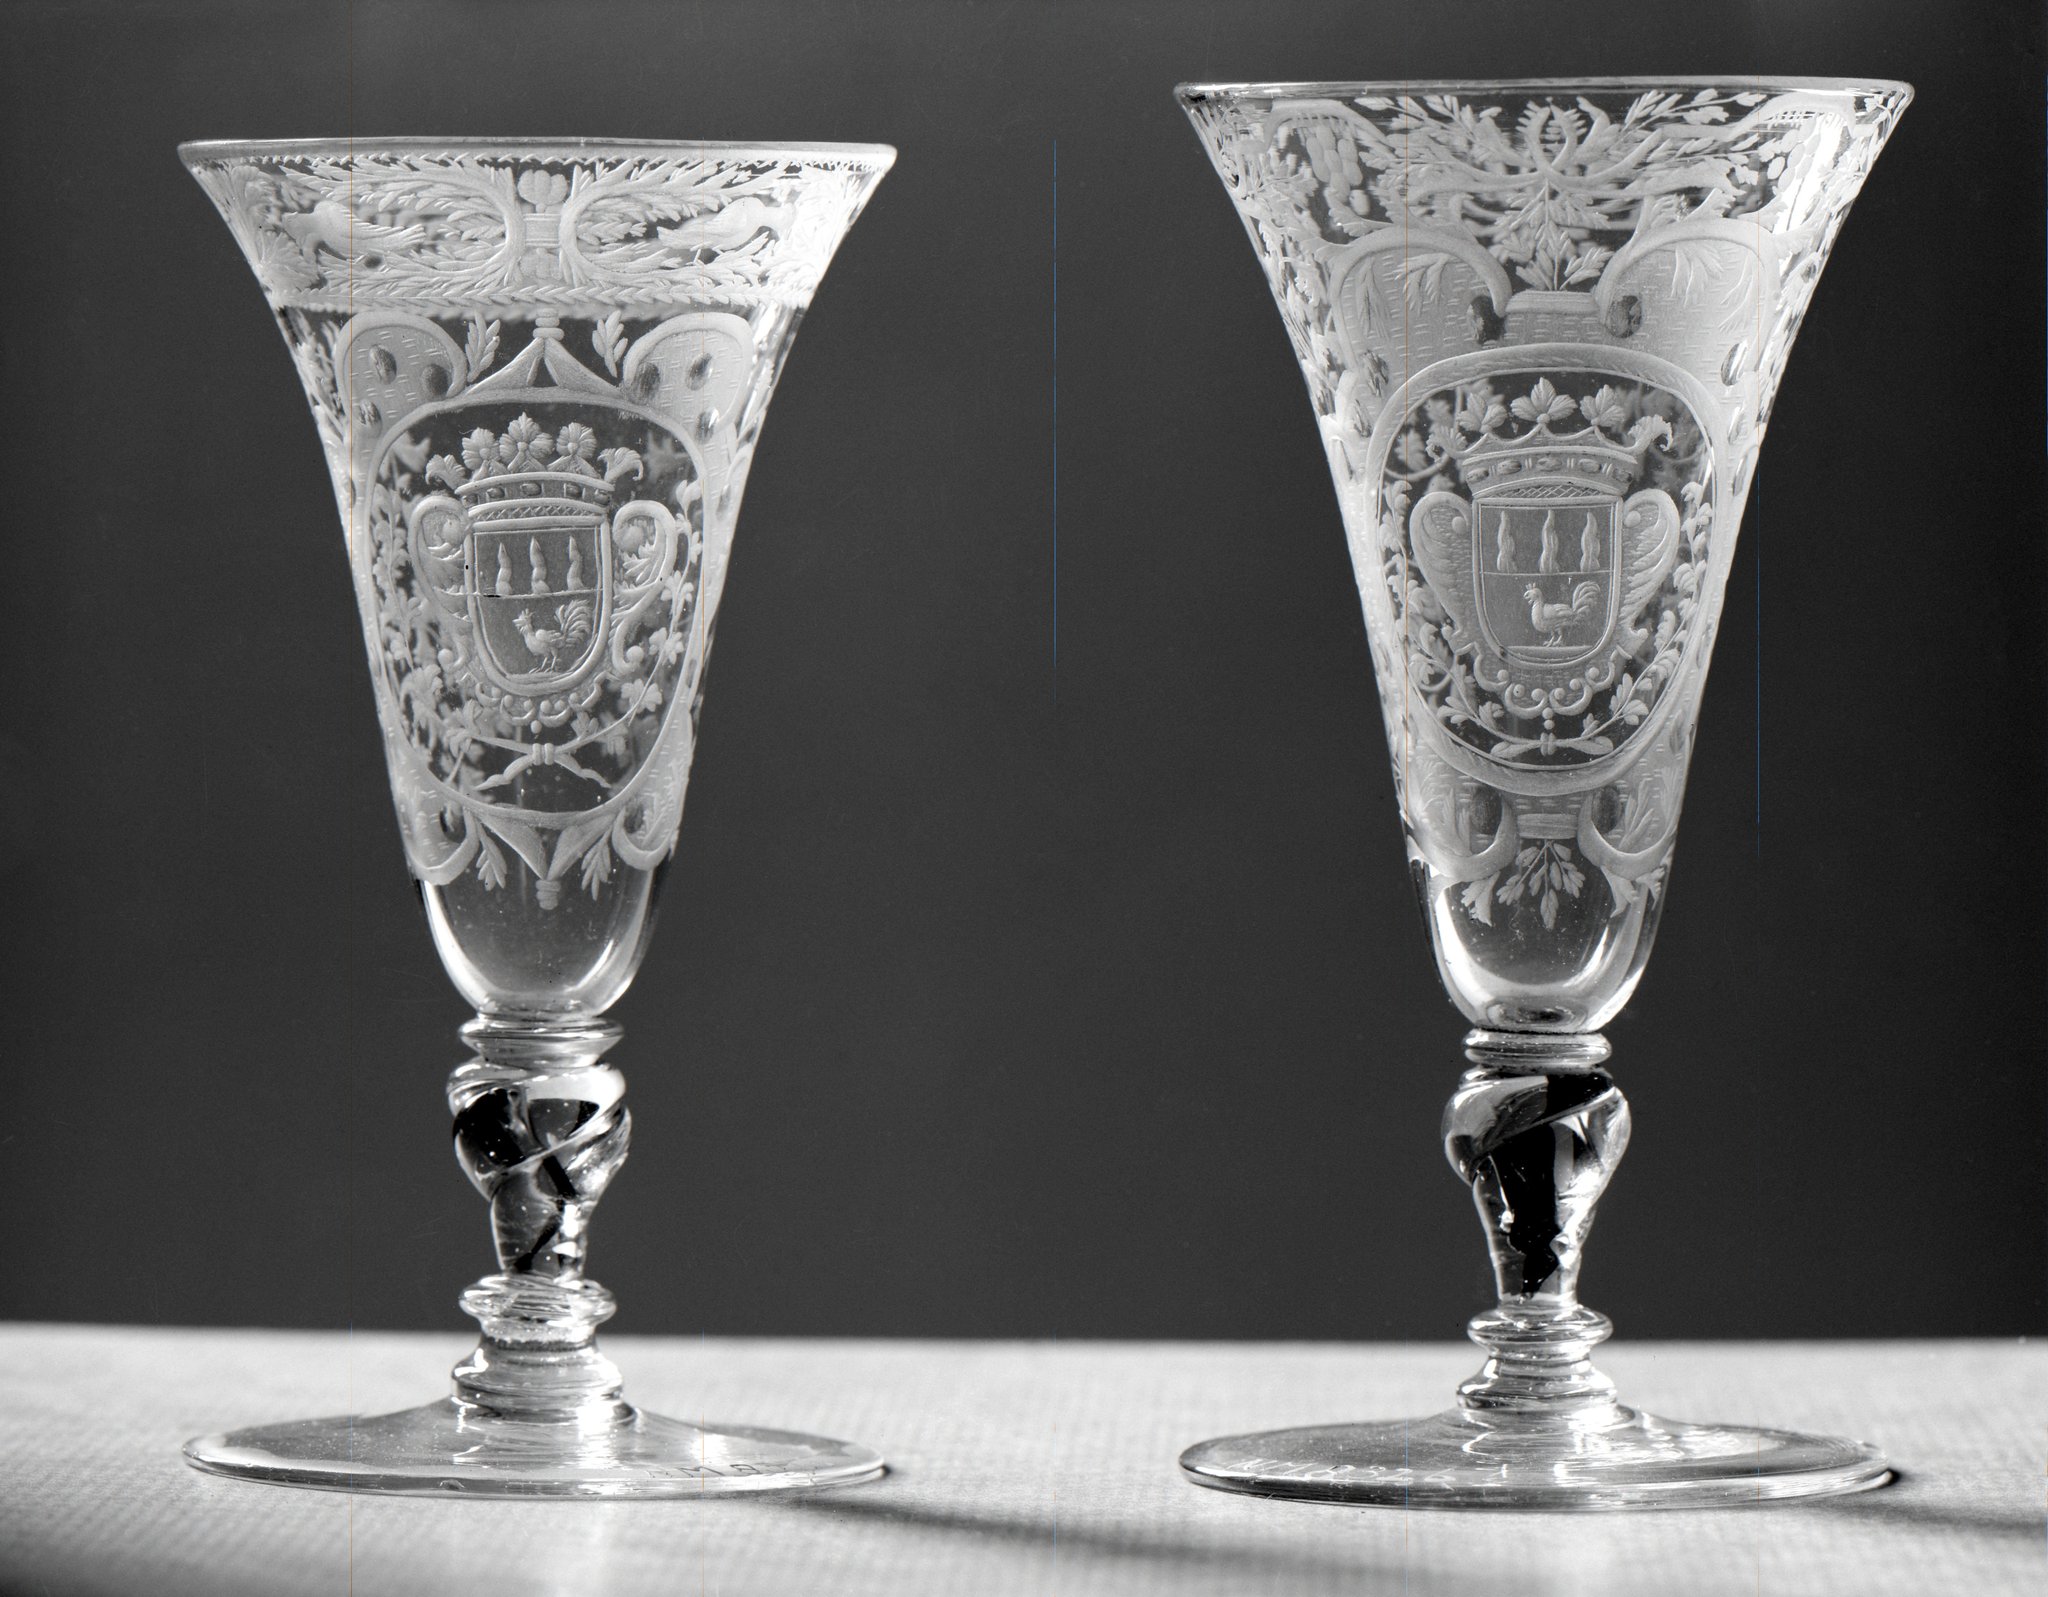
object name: goblet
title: Kelkglas met het wapen van de familie Van Beuningen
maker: Anonymous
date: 1700-1725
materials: glass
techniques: glassblowing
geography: dresden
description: Two wine glasses. Wheel engraving with the coat of arms of the Van Beuningen family. Dresden, c. 1700 - 1725. R. van Beuningen van Helsdingen bequest, 1923.